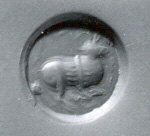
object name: stamp seal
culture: sasanian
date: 401-700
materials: stone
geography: iran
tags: animals